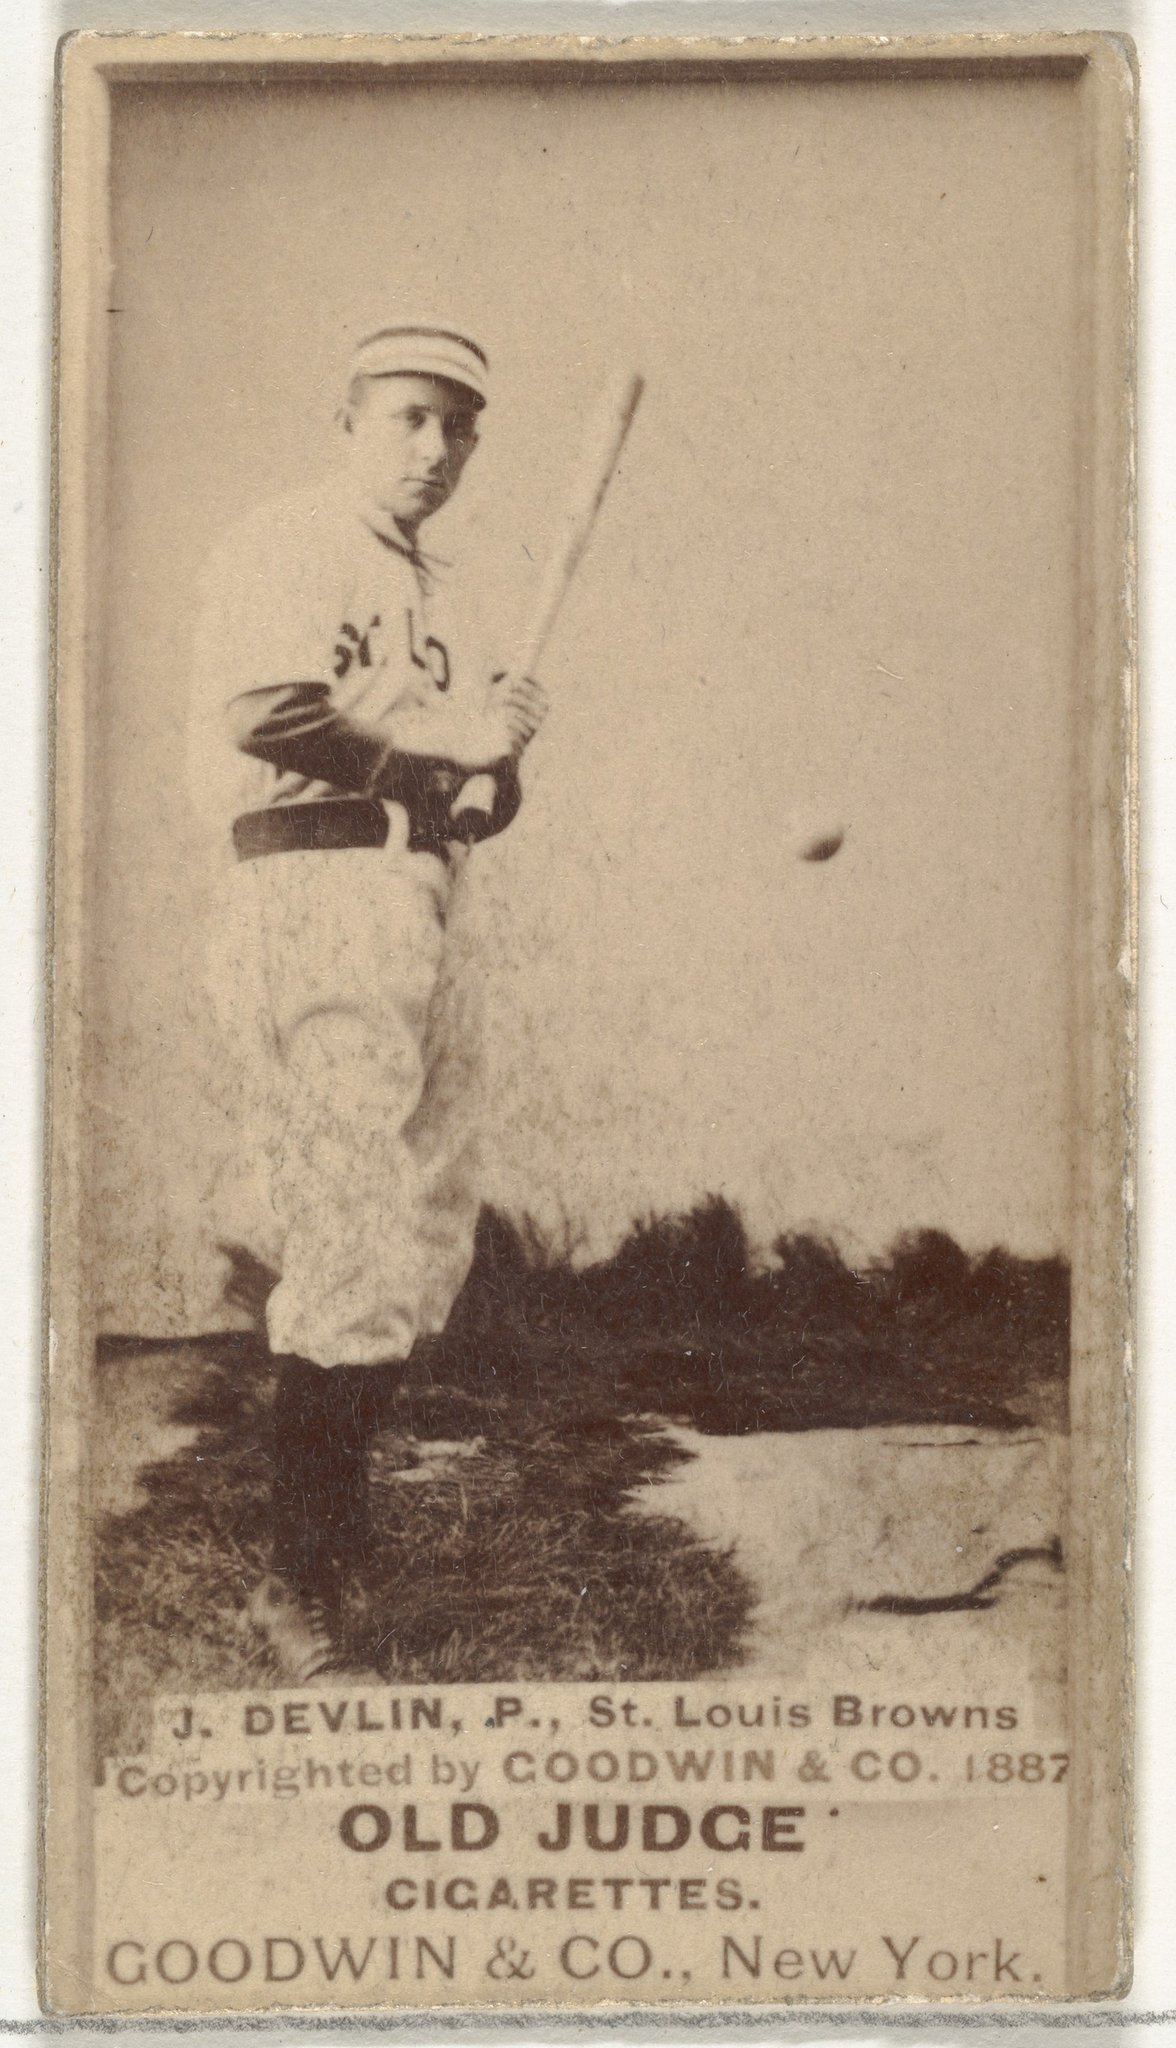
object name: baseball card, photograph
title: James H. "Jim" Devlin, Pitcher, St. Louis Browns, from the Old Judge series (N172) for Old Judge Cigarettes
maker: goodwin & company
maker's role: publisher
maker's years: 1850-1950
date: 1887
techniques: albumen silver print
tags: men,portraits,baseball,athletes